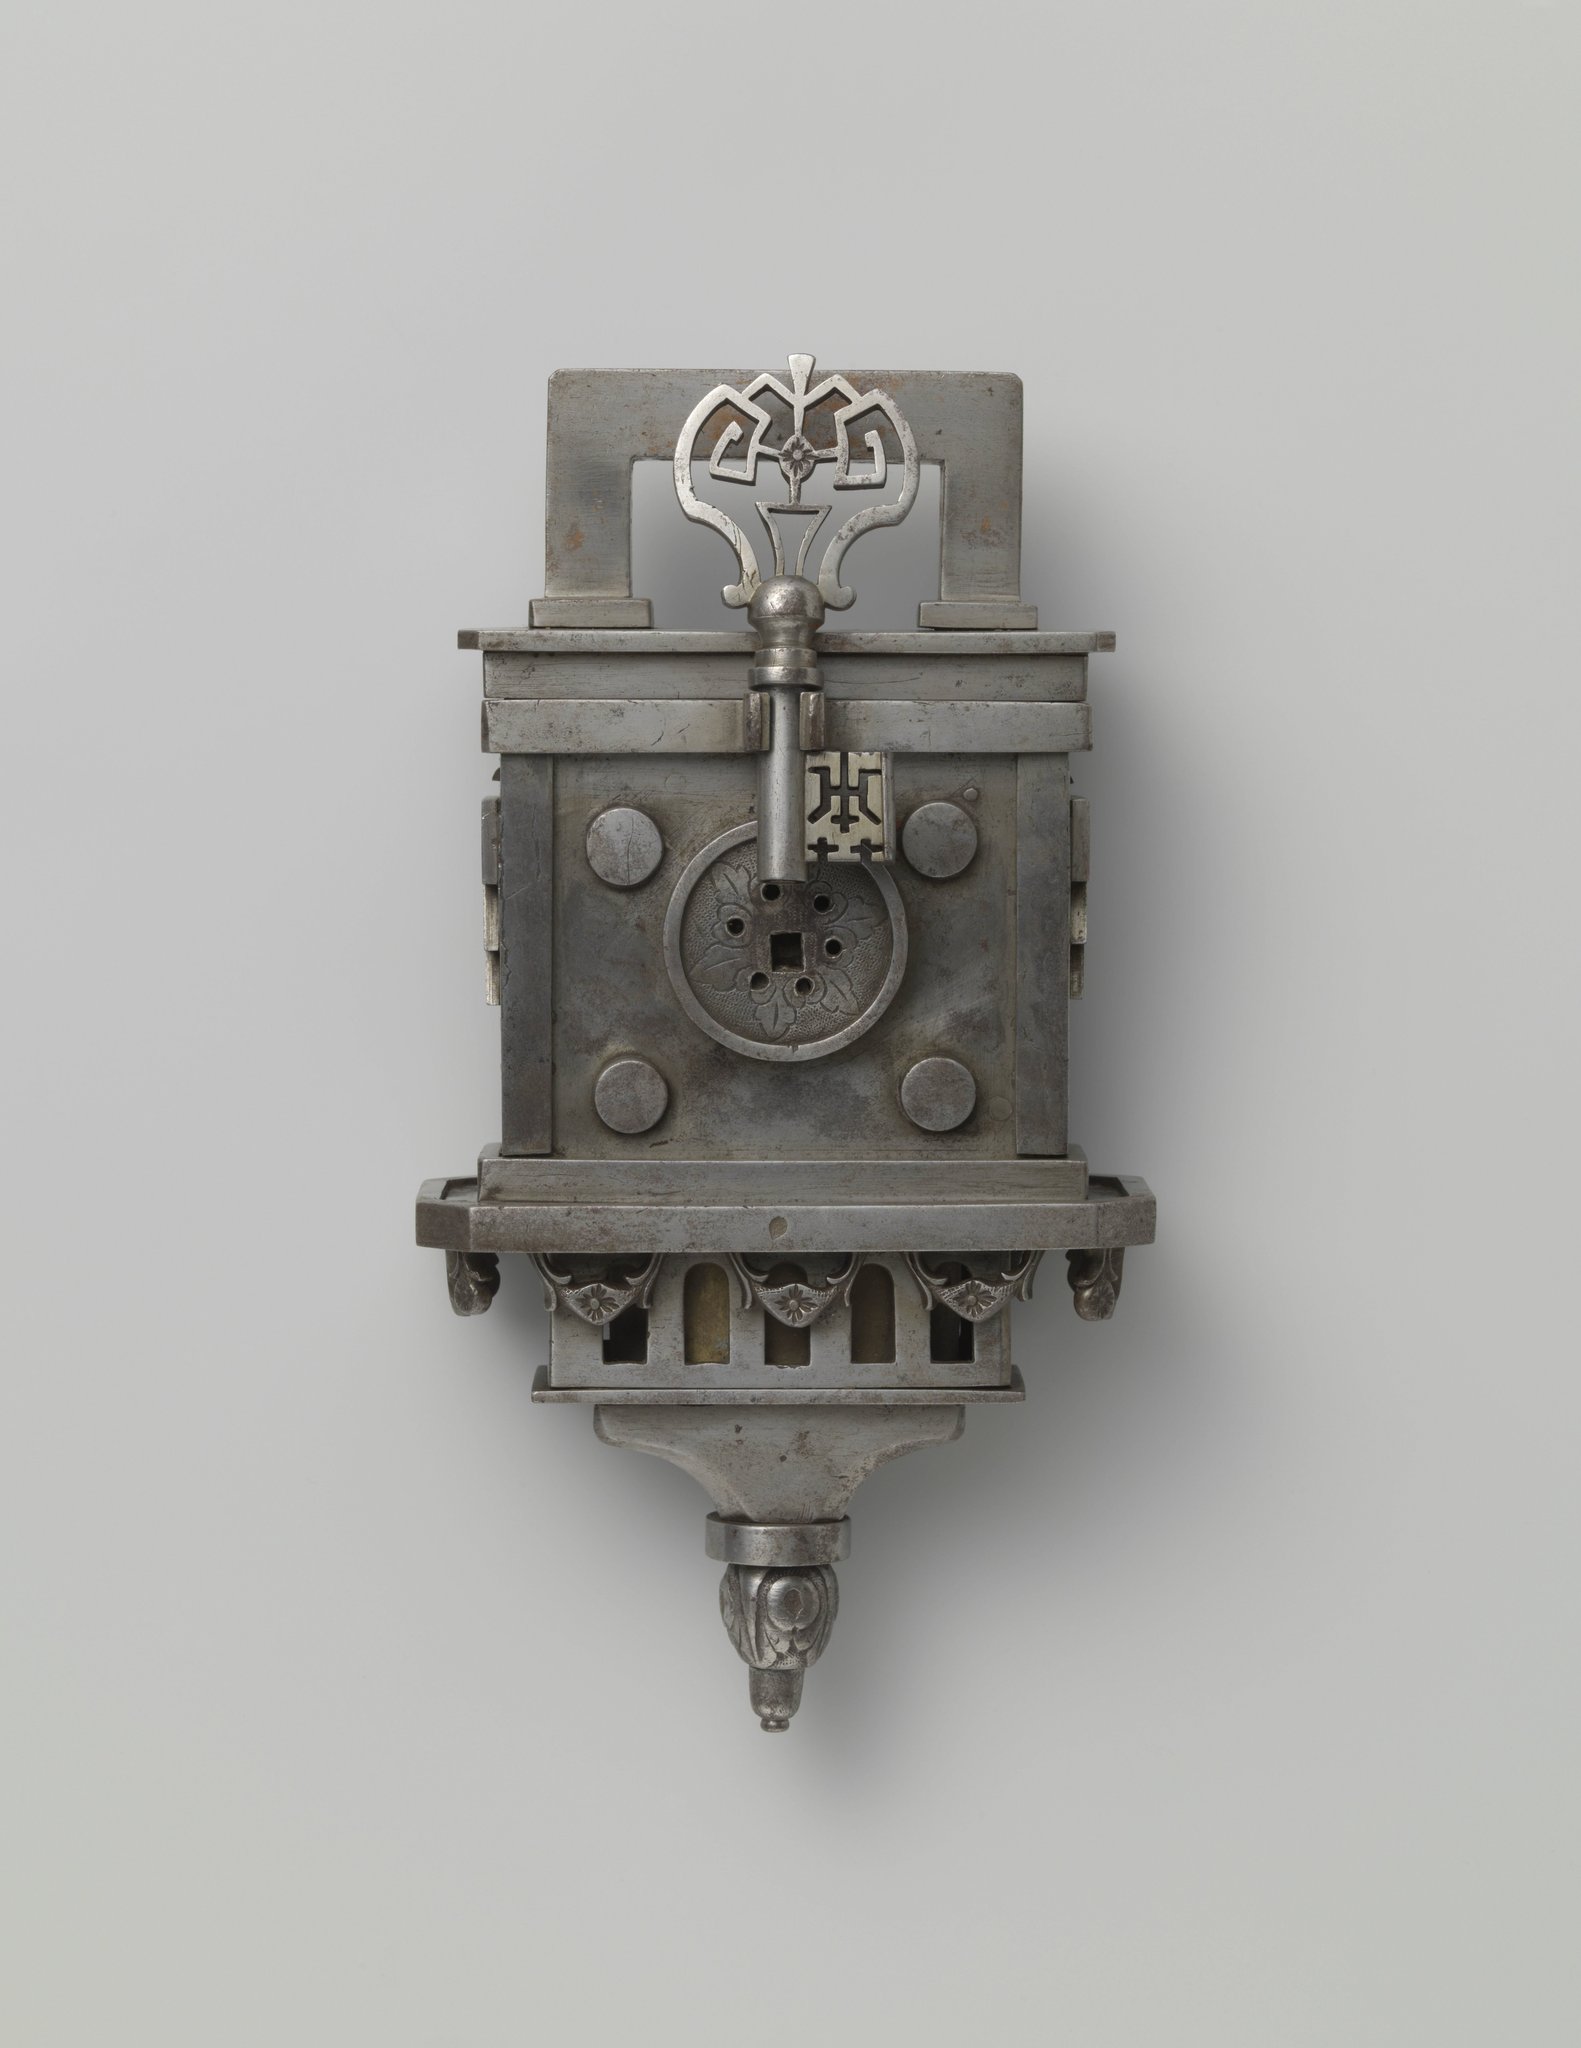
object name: padlock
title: Hangslot met sleutel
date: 1400-1950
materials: iron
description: Hangslot, zeer samengesteld, met sleutel. Gemerkt.